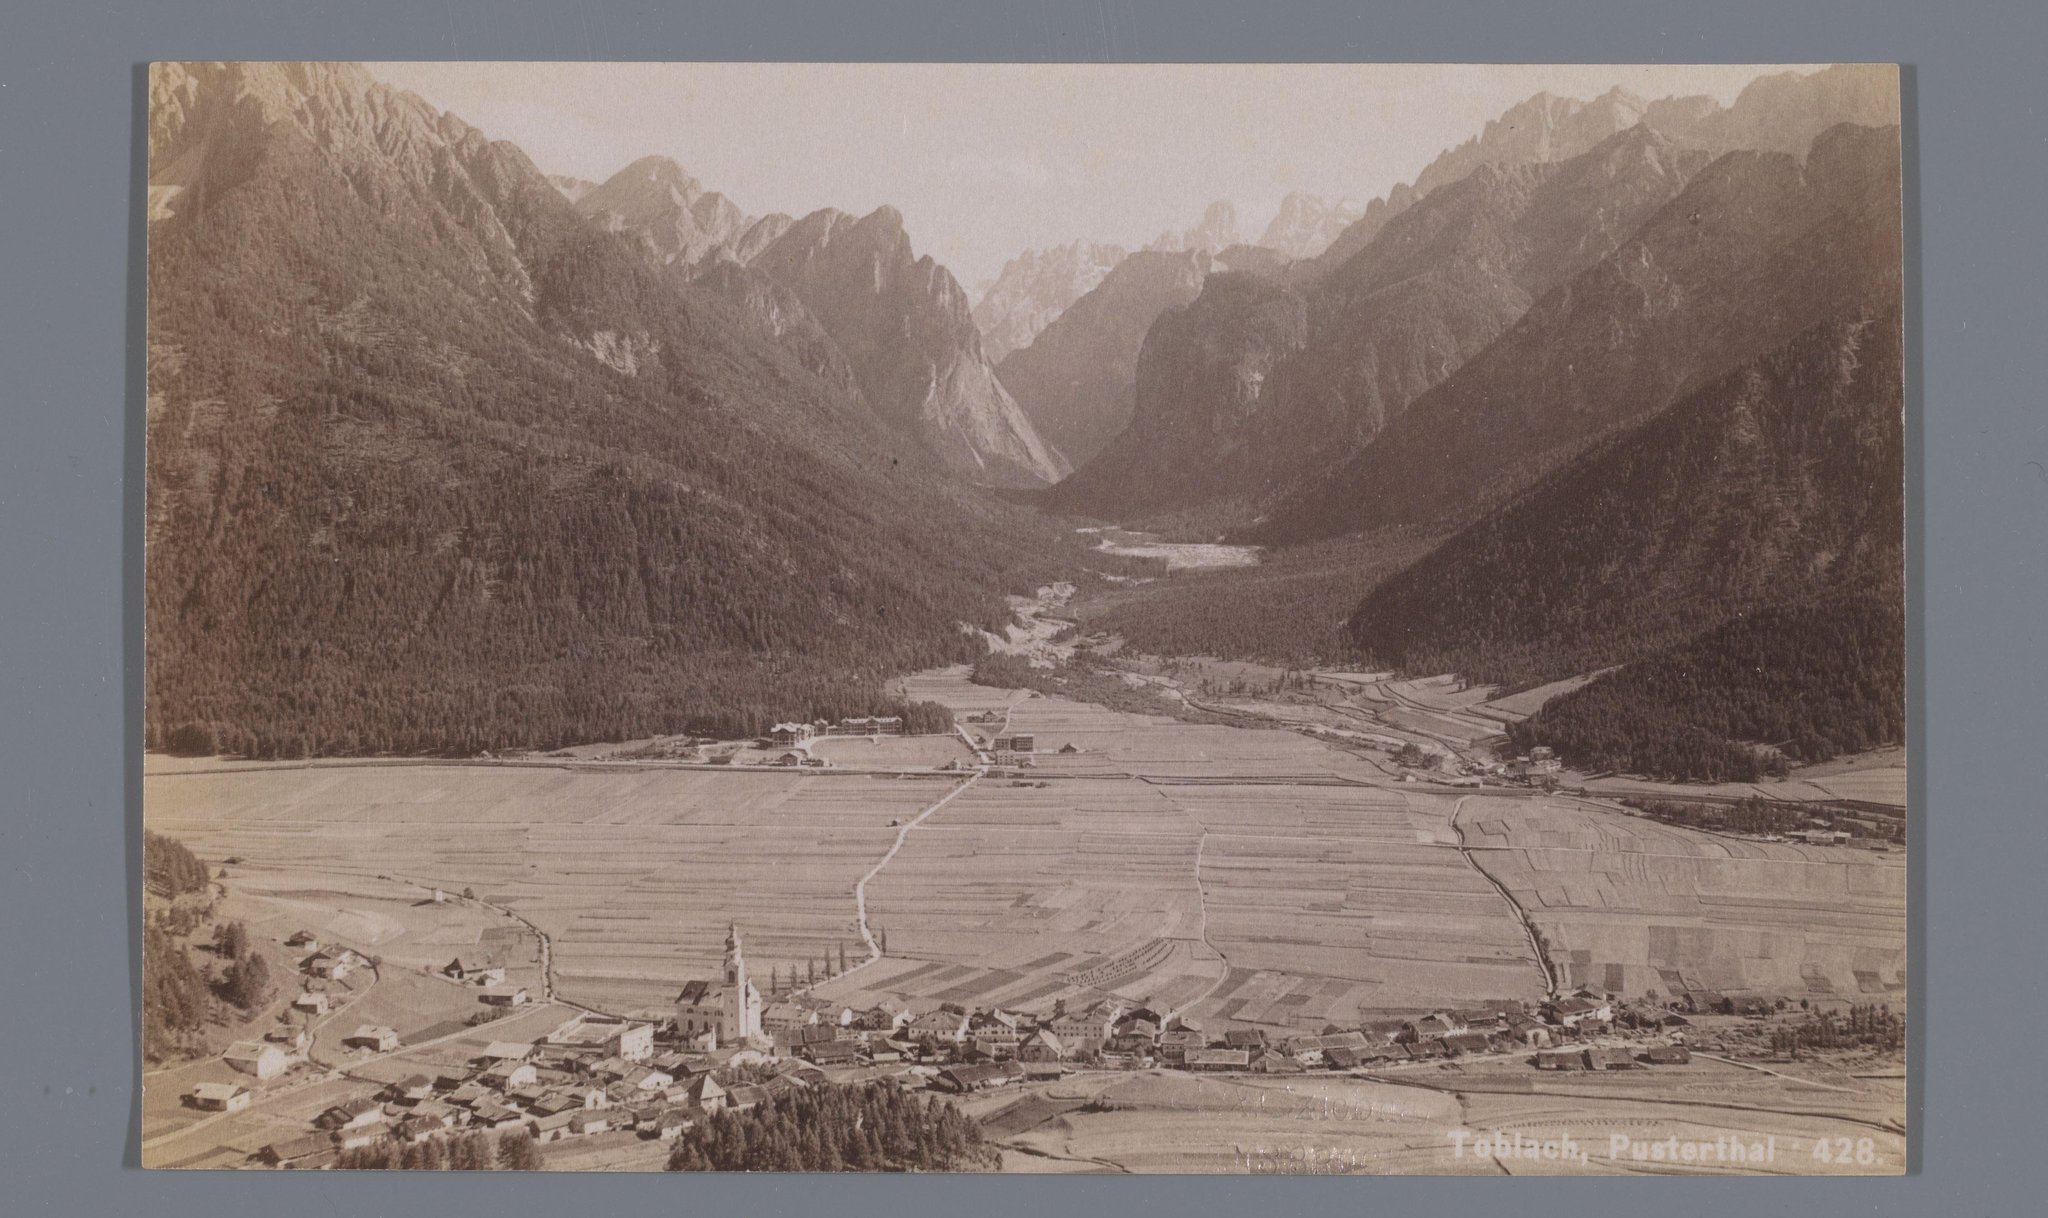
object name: photograph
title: Gezicht op Toblach en het Pustertal, Italië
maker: carl alexander czichna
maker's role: publisher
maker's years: 1811-1867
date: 1860-1867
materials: paper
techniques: albumen print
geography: toblach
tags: dale, valley, mountains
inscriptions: number: ‘428’